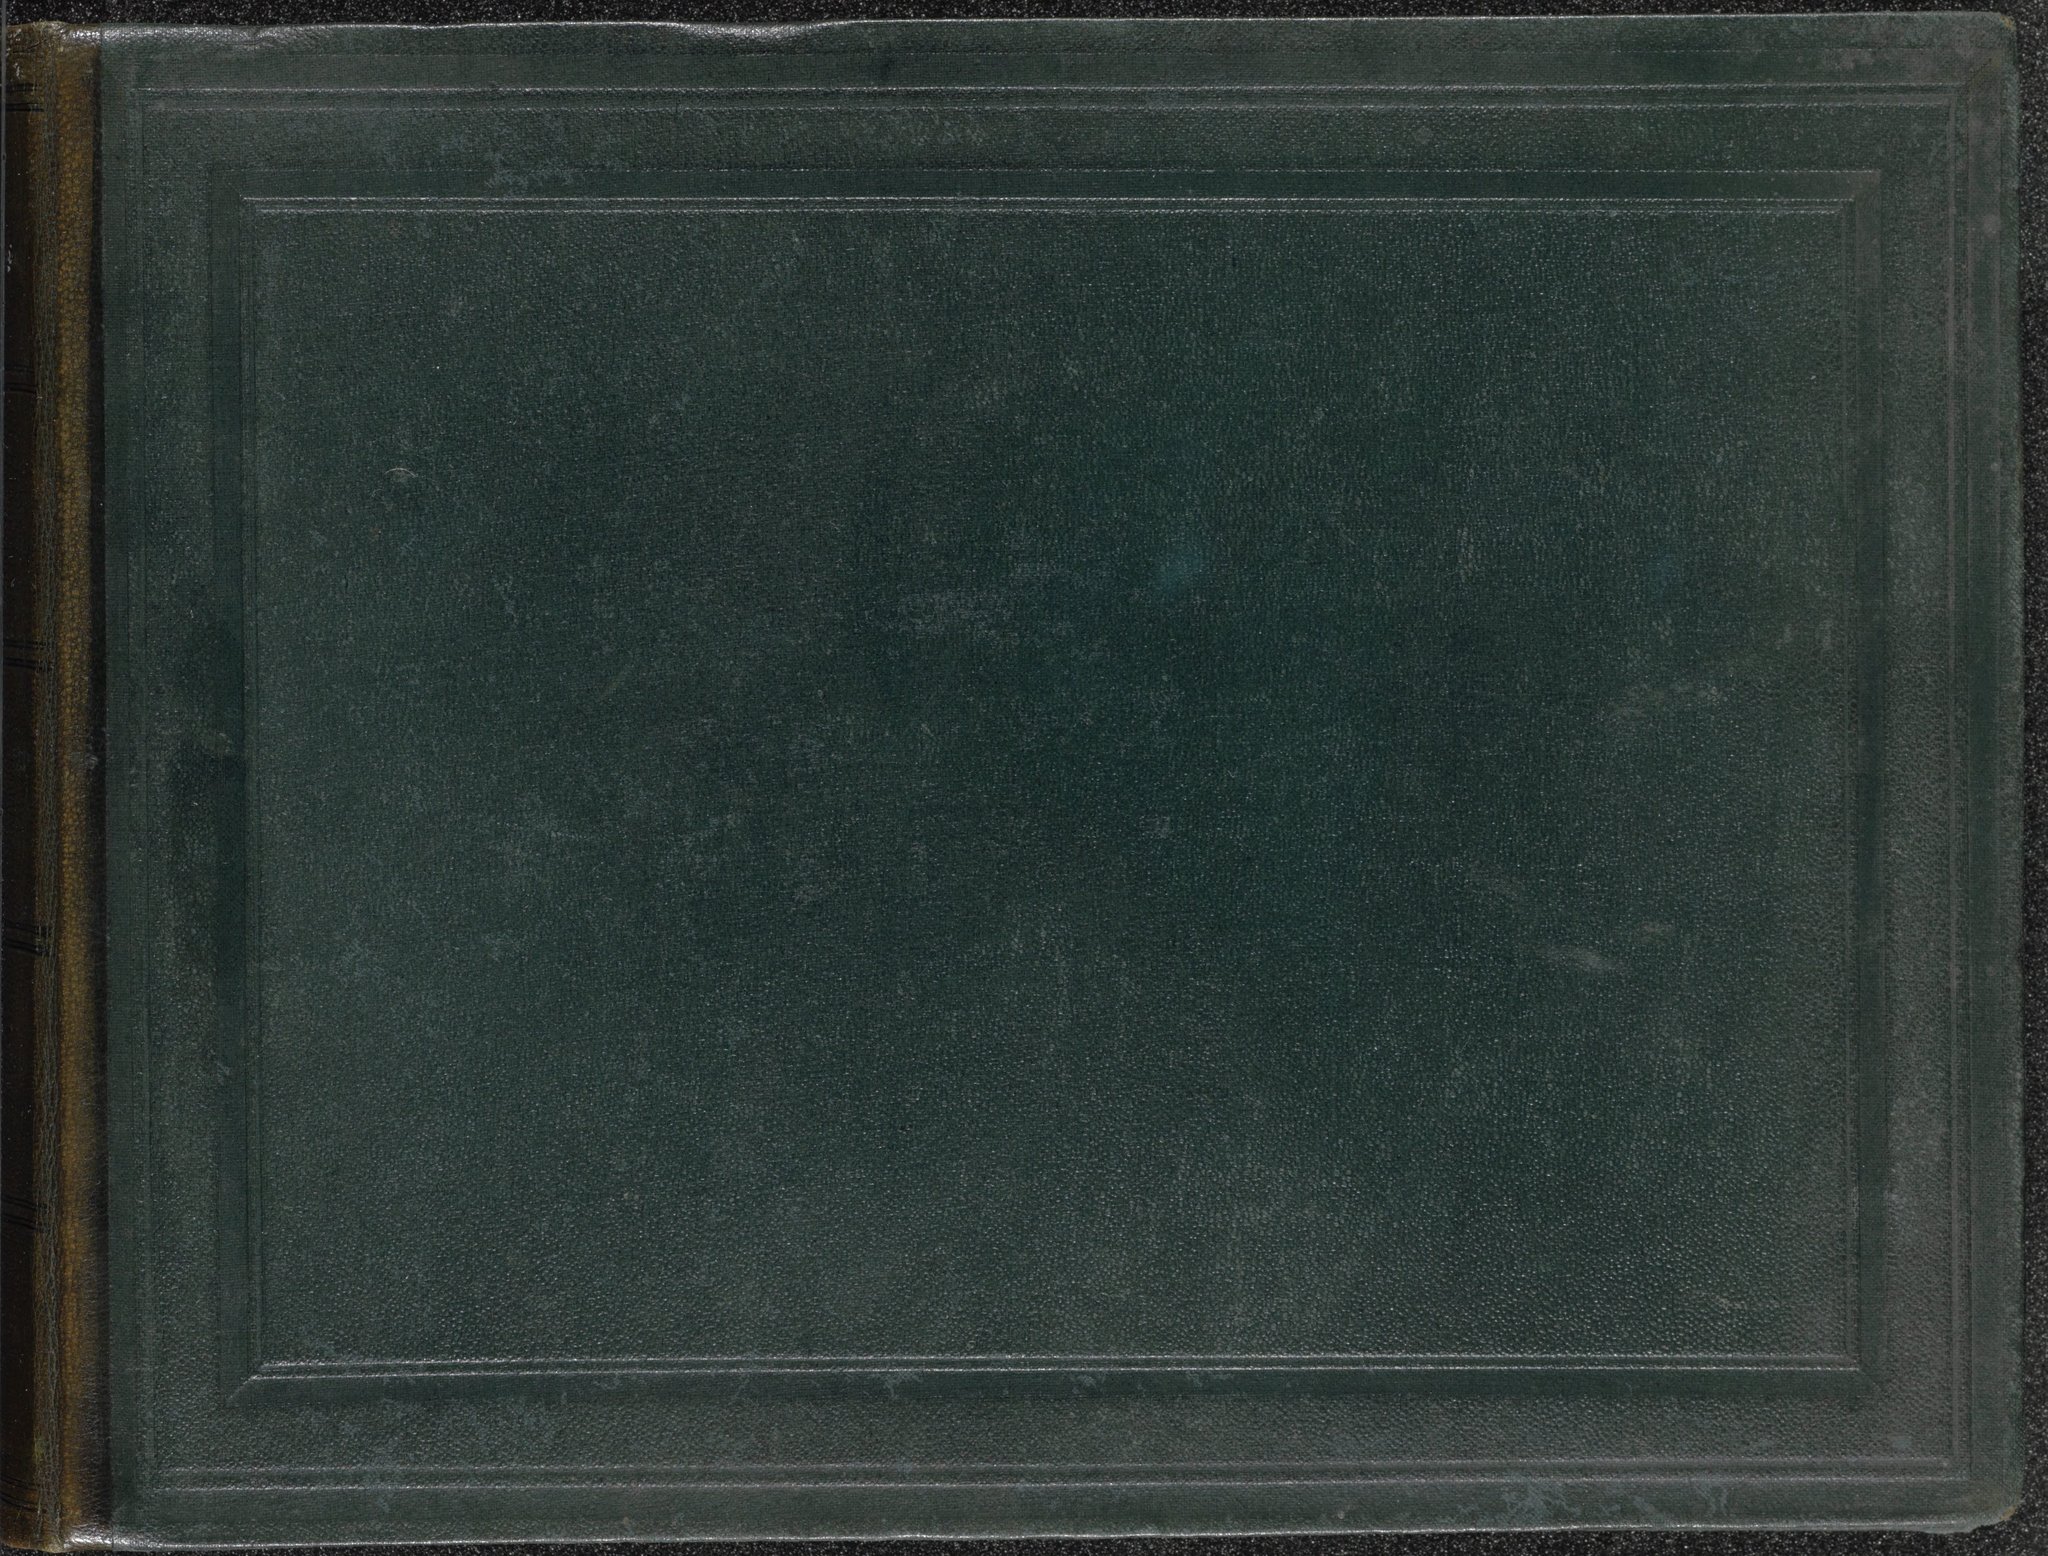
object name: photograph album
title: Fotoalbum met familiefoto's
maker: Anonymous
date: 1885-1914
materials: cardboard, leather, photographic support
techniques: gelatin silver print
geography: france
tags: france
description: Fotoalbum met familiefoto's van (vermoedelijk) Franse volwassenen en jonge kinderen. Het zijn binnen- en buitenopnames, waarop doorgaans de kinderen centraal staan. Het album bevat 25 kartonnen bladen met 33 foto's. De band van het album is bekleed met donkergroen leer. De voor- en achterzijde hebben een liggende rechthoek in reliëf.